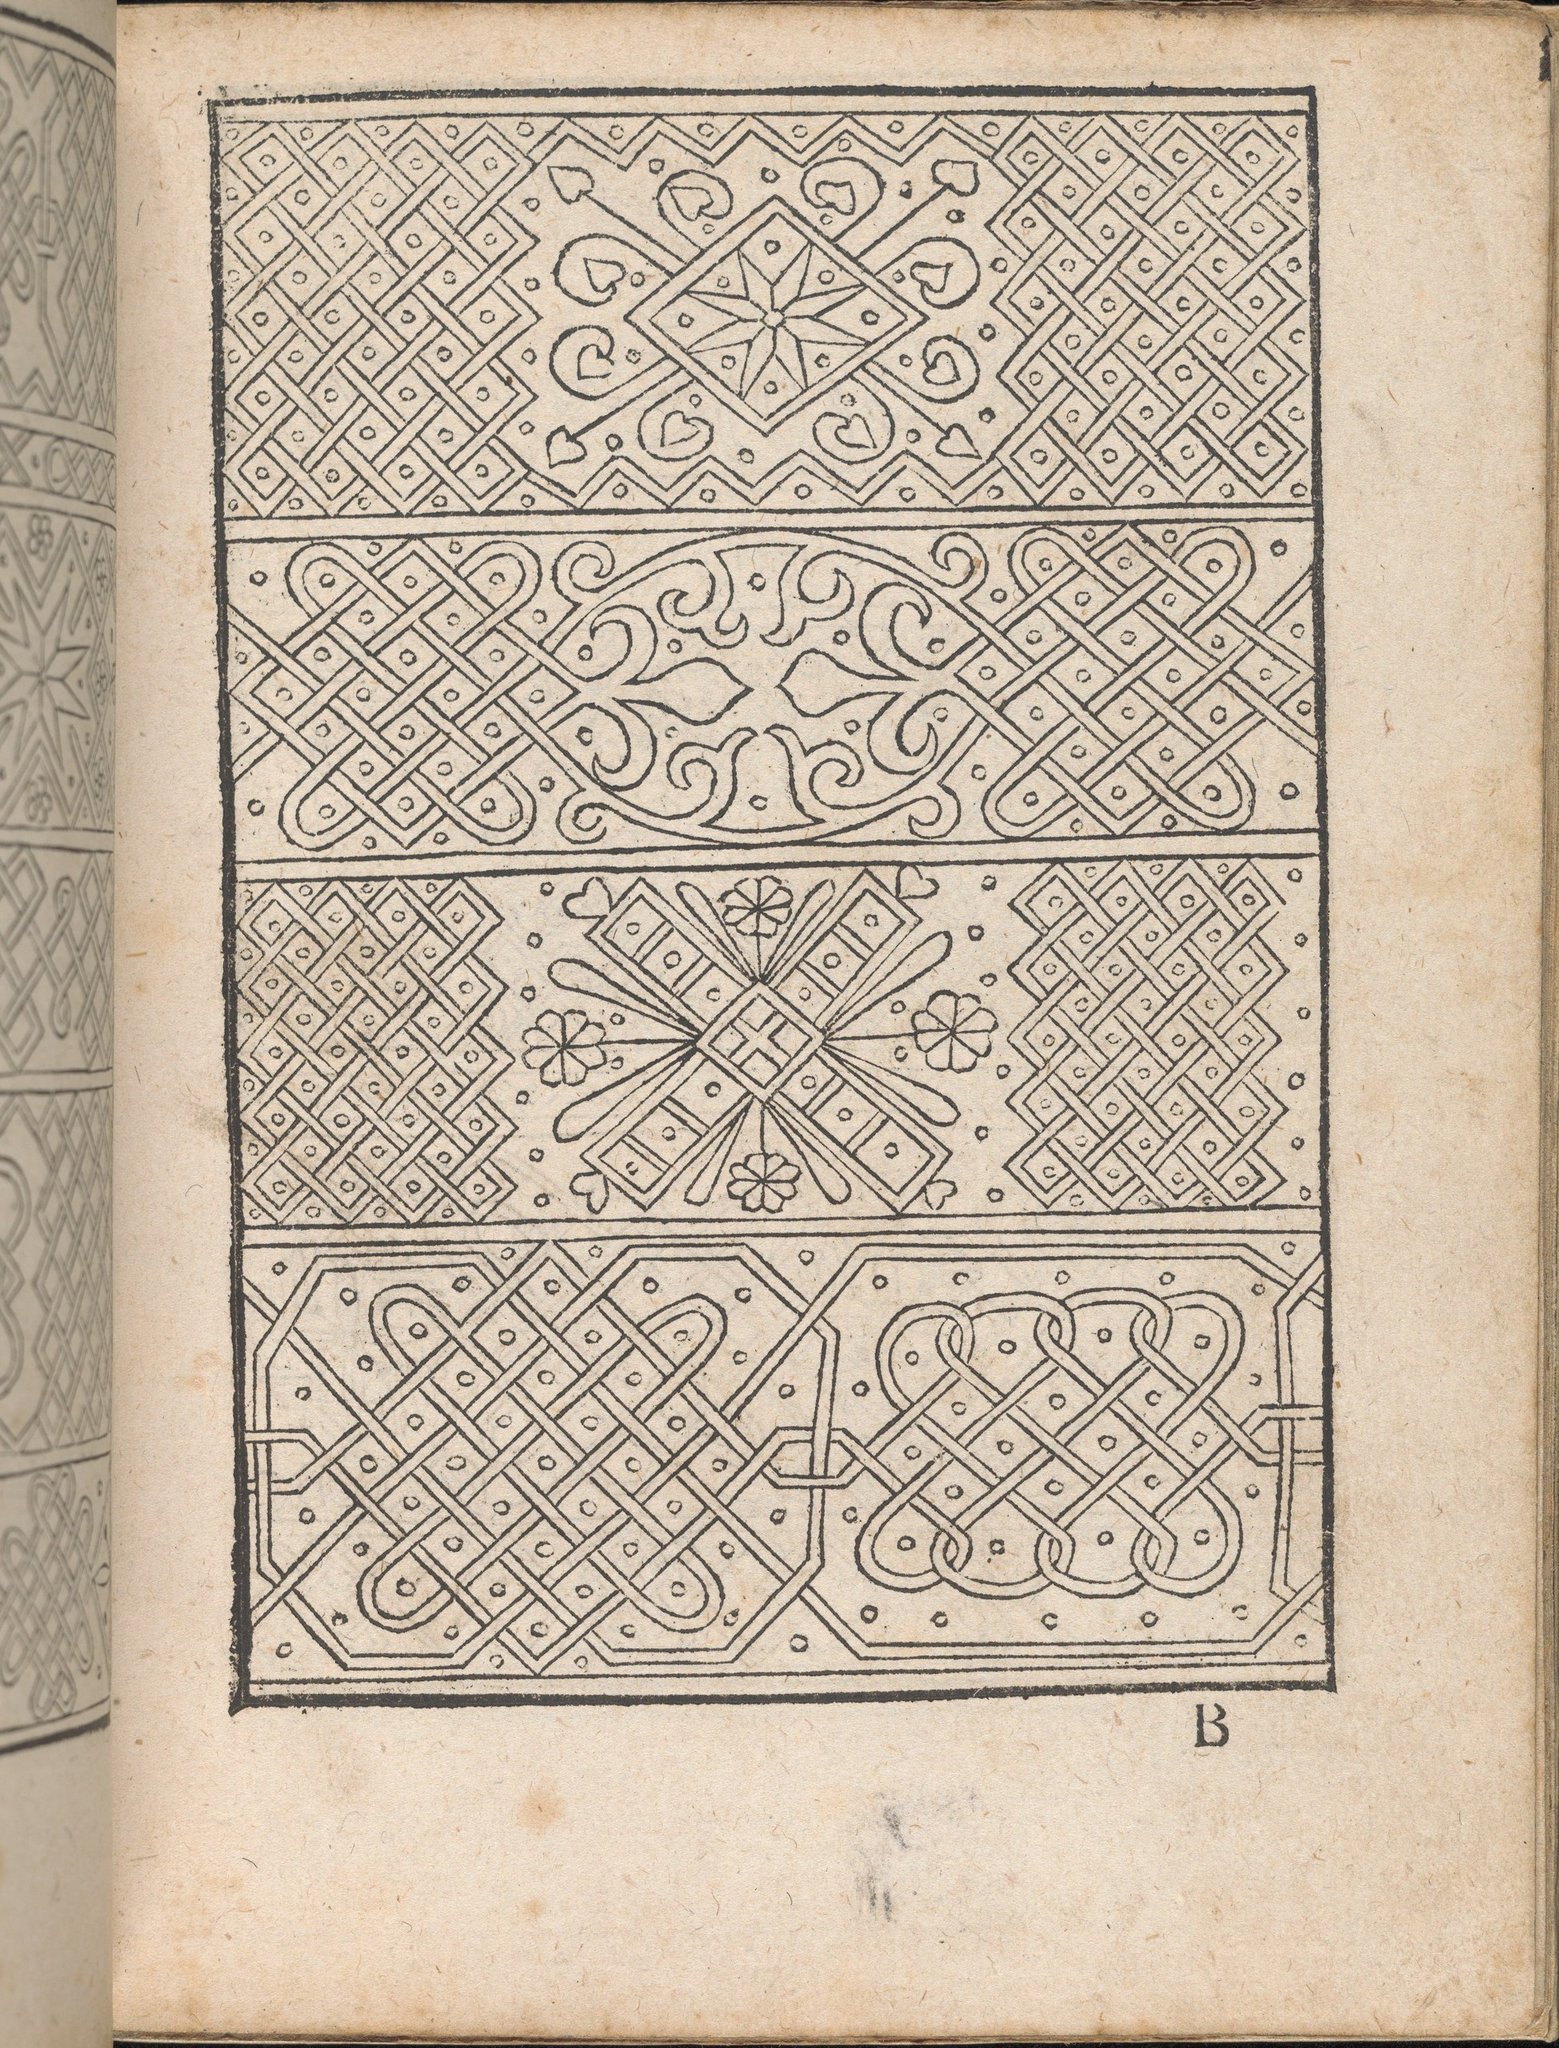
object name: book print ornament architecture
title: New Modelbüch allen Nägerin u. Sydenstickern (Page 5r)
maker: hans hoffman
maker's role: designer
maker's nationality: german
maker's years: 1556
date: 1556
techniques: woodcut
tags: ornament